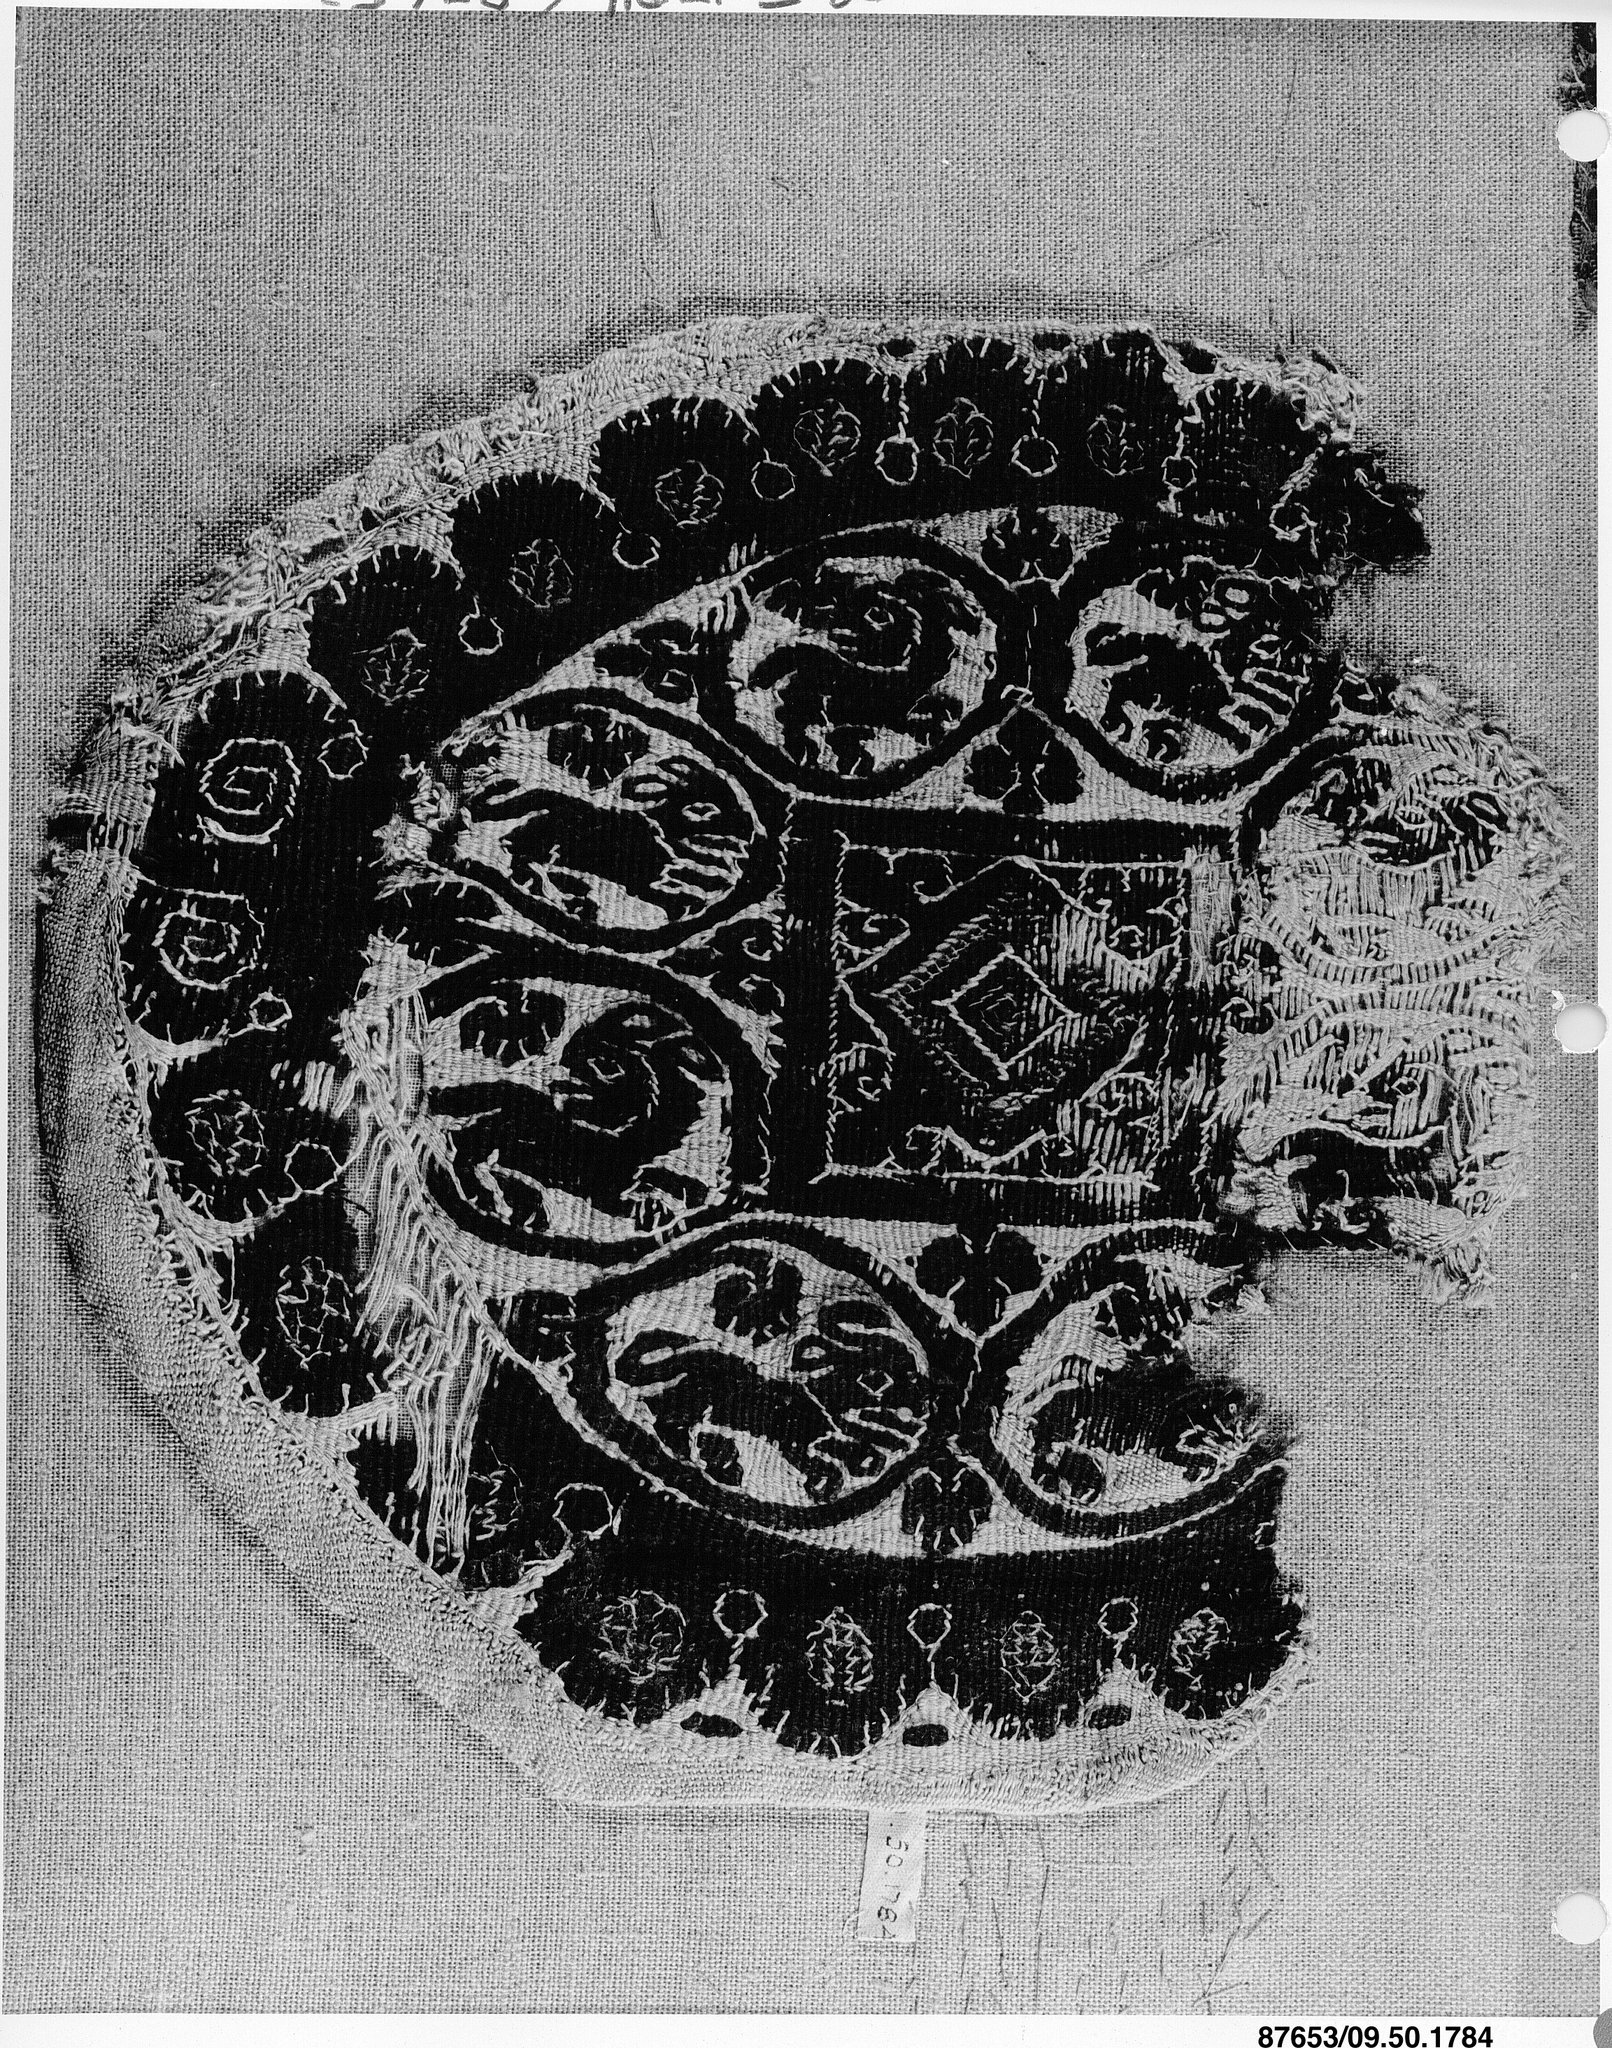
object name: roundel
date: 301-500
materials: linen, wool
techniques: weave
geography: egypt